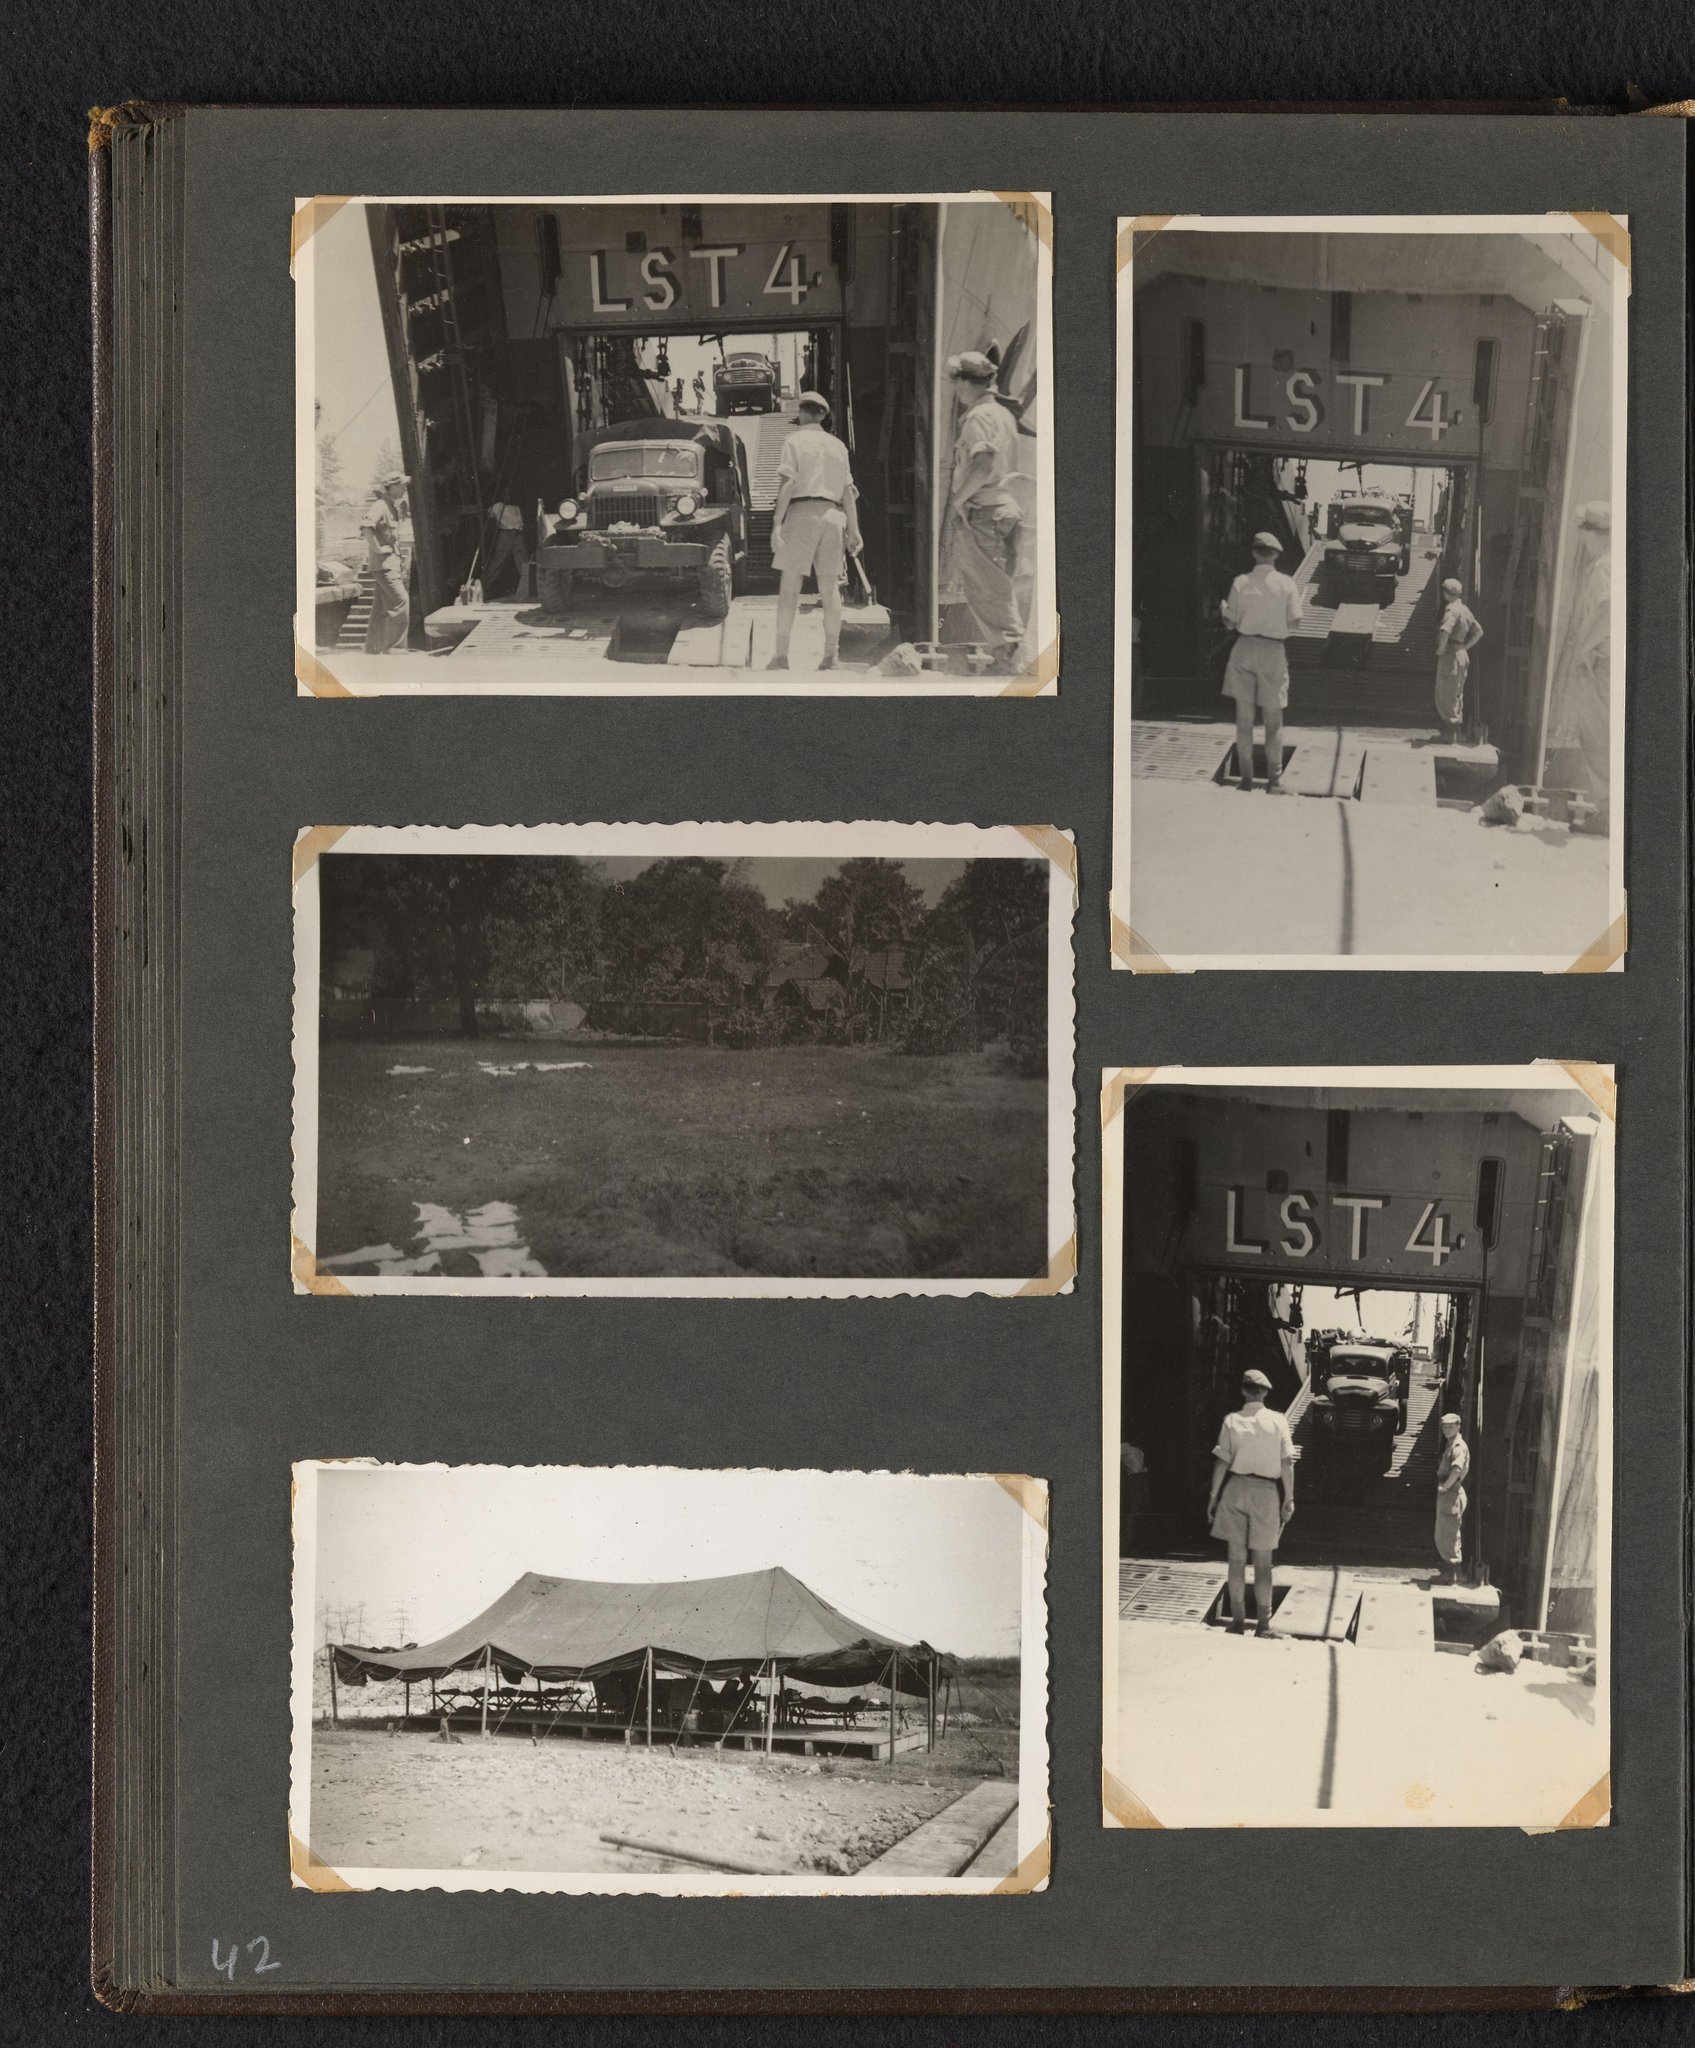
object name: photograph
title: Ontscheping in Soerabaja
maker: Anonymous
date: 1949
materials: cardboard, photographic support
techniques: gelatin silver print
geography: dutch east indies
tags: troop movements, transportation, dutch east indies, the, surabaya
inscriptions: inscription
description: Albumblad met vijf foto's van de ontscheping van militair materiaal in Soerabaja, en van een tent van de BPM. Onderdeel van het fotoalbum 'Mijn jaren in Indië' met foto's over de militaire acties in Nederlands-Indië.